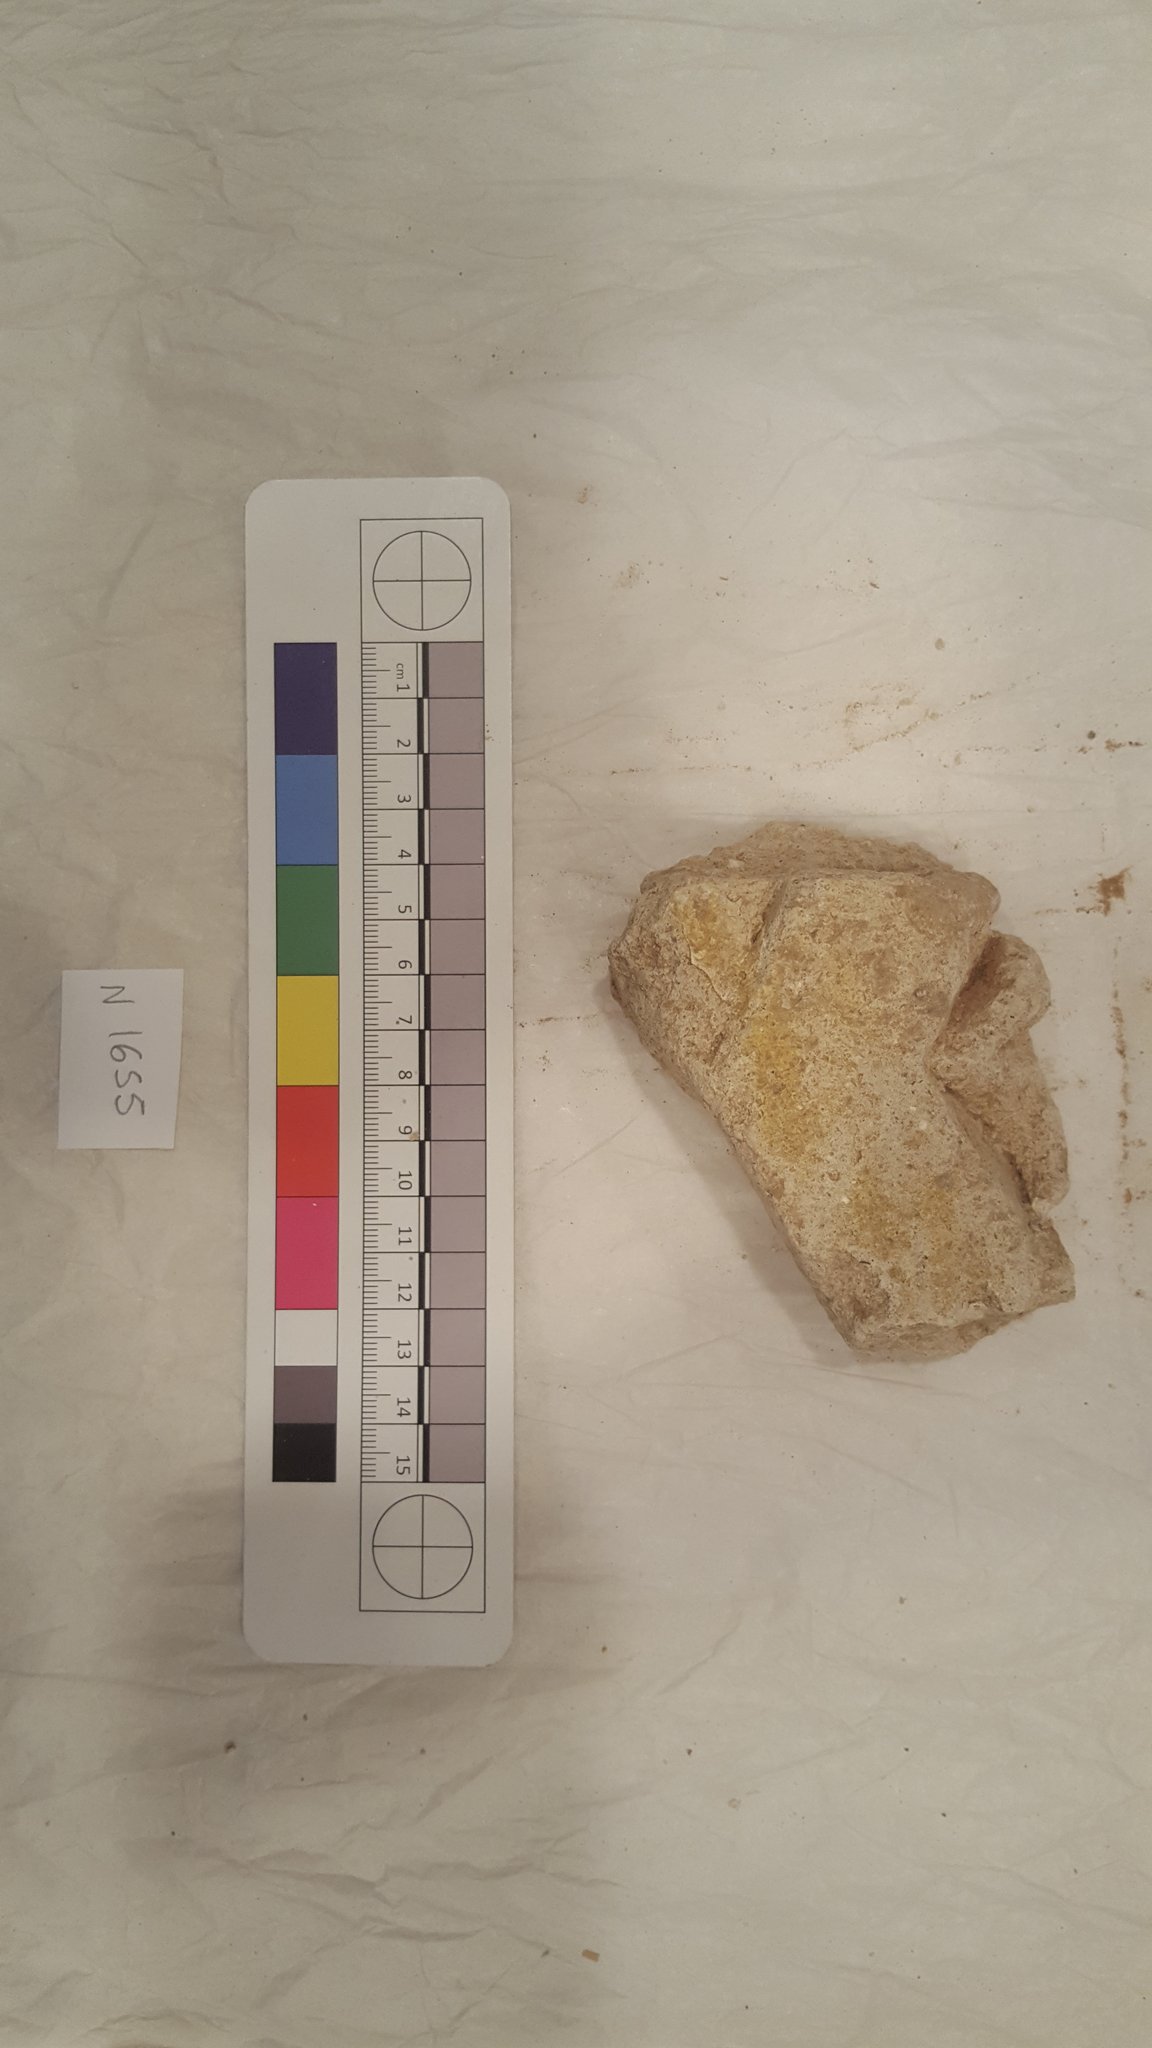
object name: fragment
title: Stucco Fragment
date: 701-1200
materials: plaster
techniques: carving, painting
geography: iran